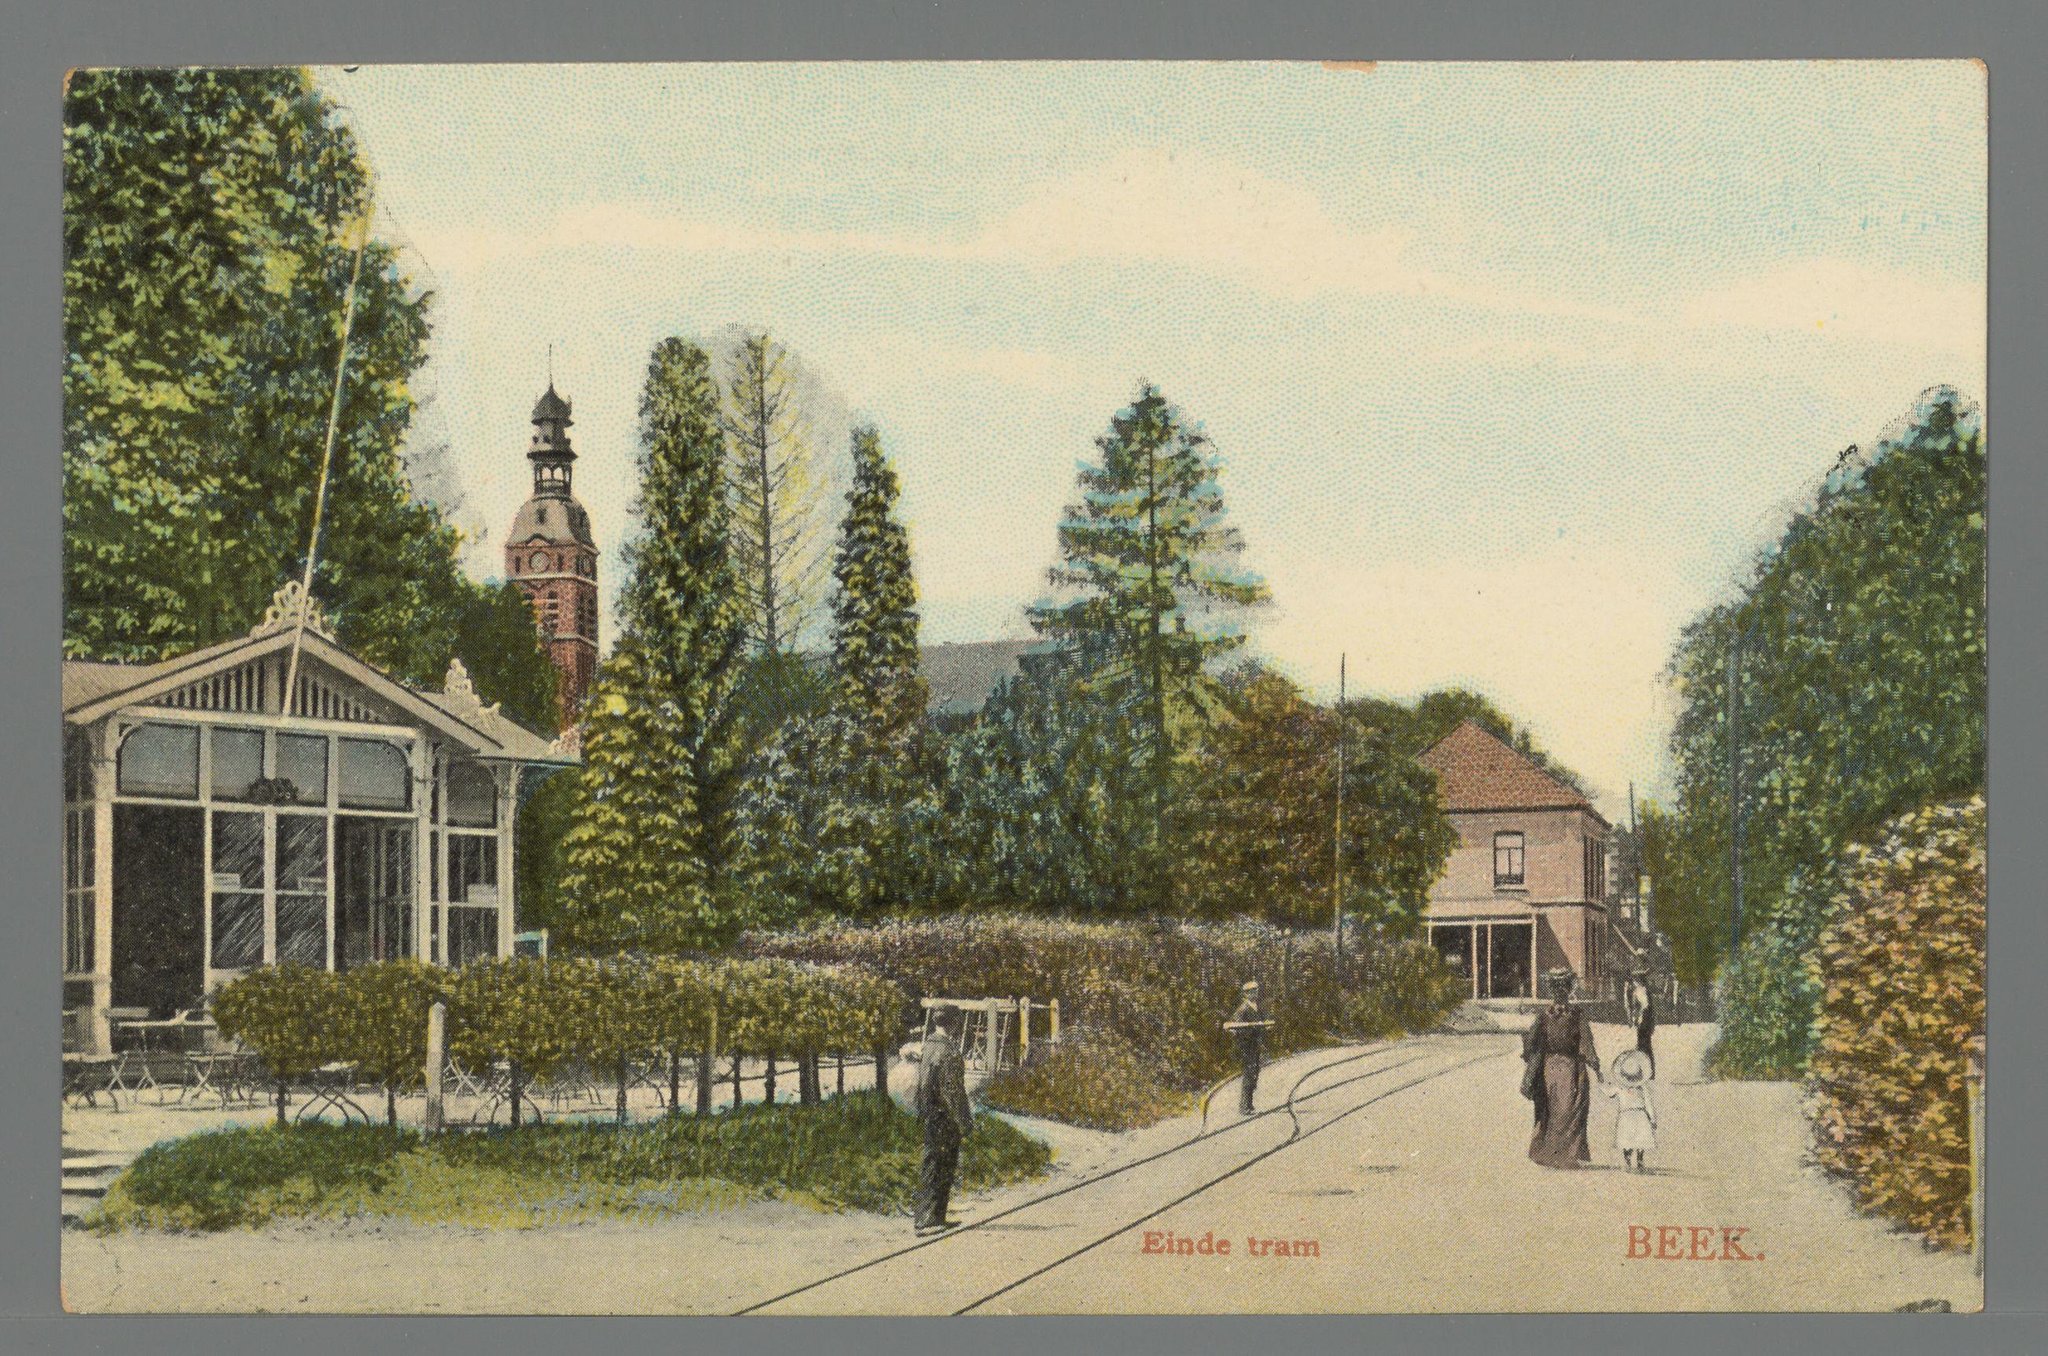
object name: photomechanical print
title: Einde tram. Beek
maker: Anonymous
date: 1905-1919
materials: cardboard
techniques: lithograph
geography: beek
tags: tramway, tram, church (exterior), street